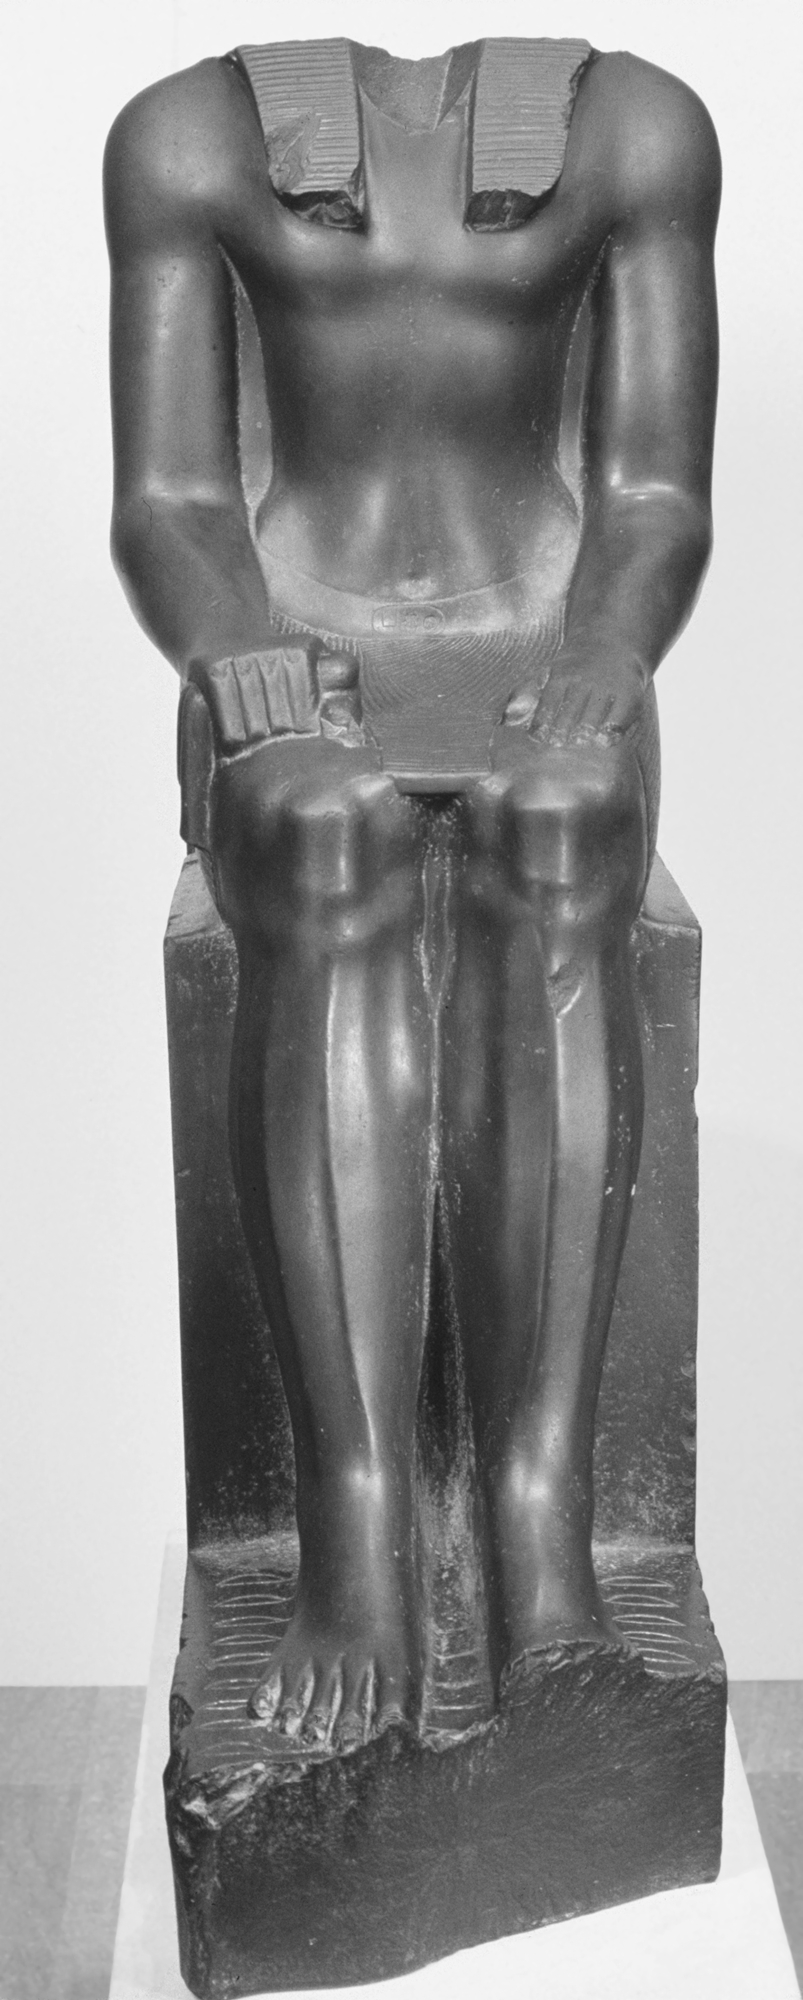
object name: statue, senwosret i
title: Seated Statue of King Senwosret I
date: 1961-1917 BCE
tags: kings,hieroglyphs